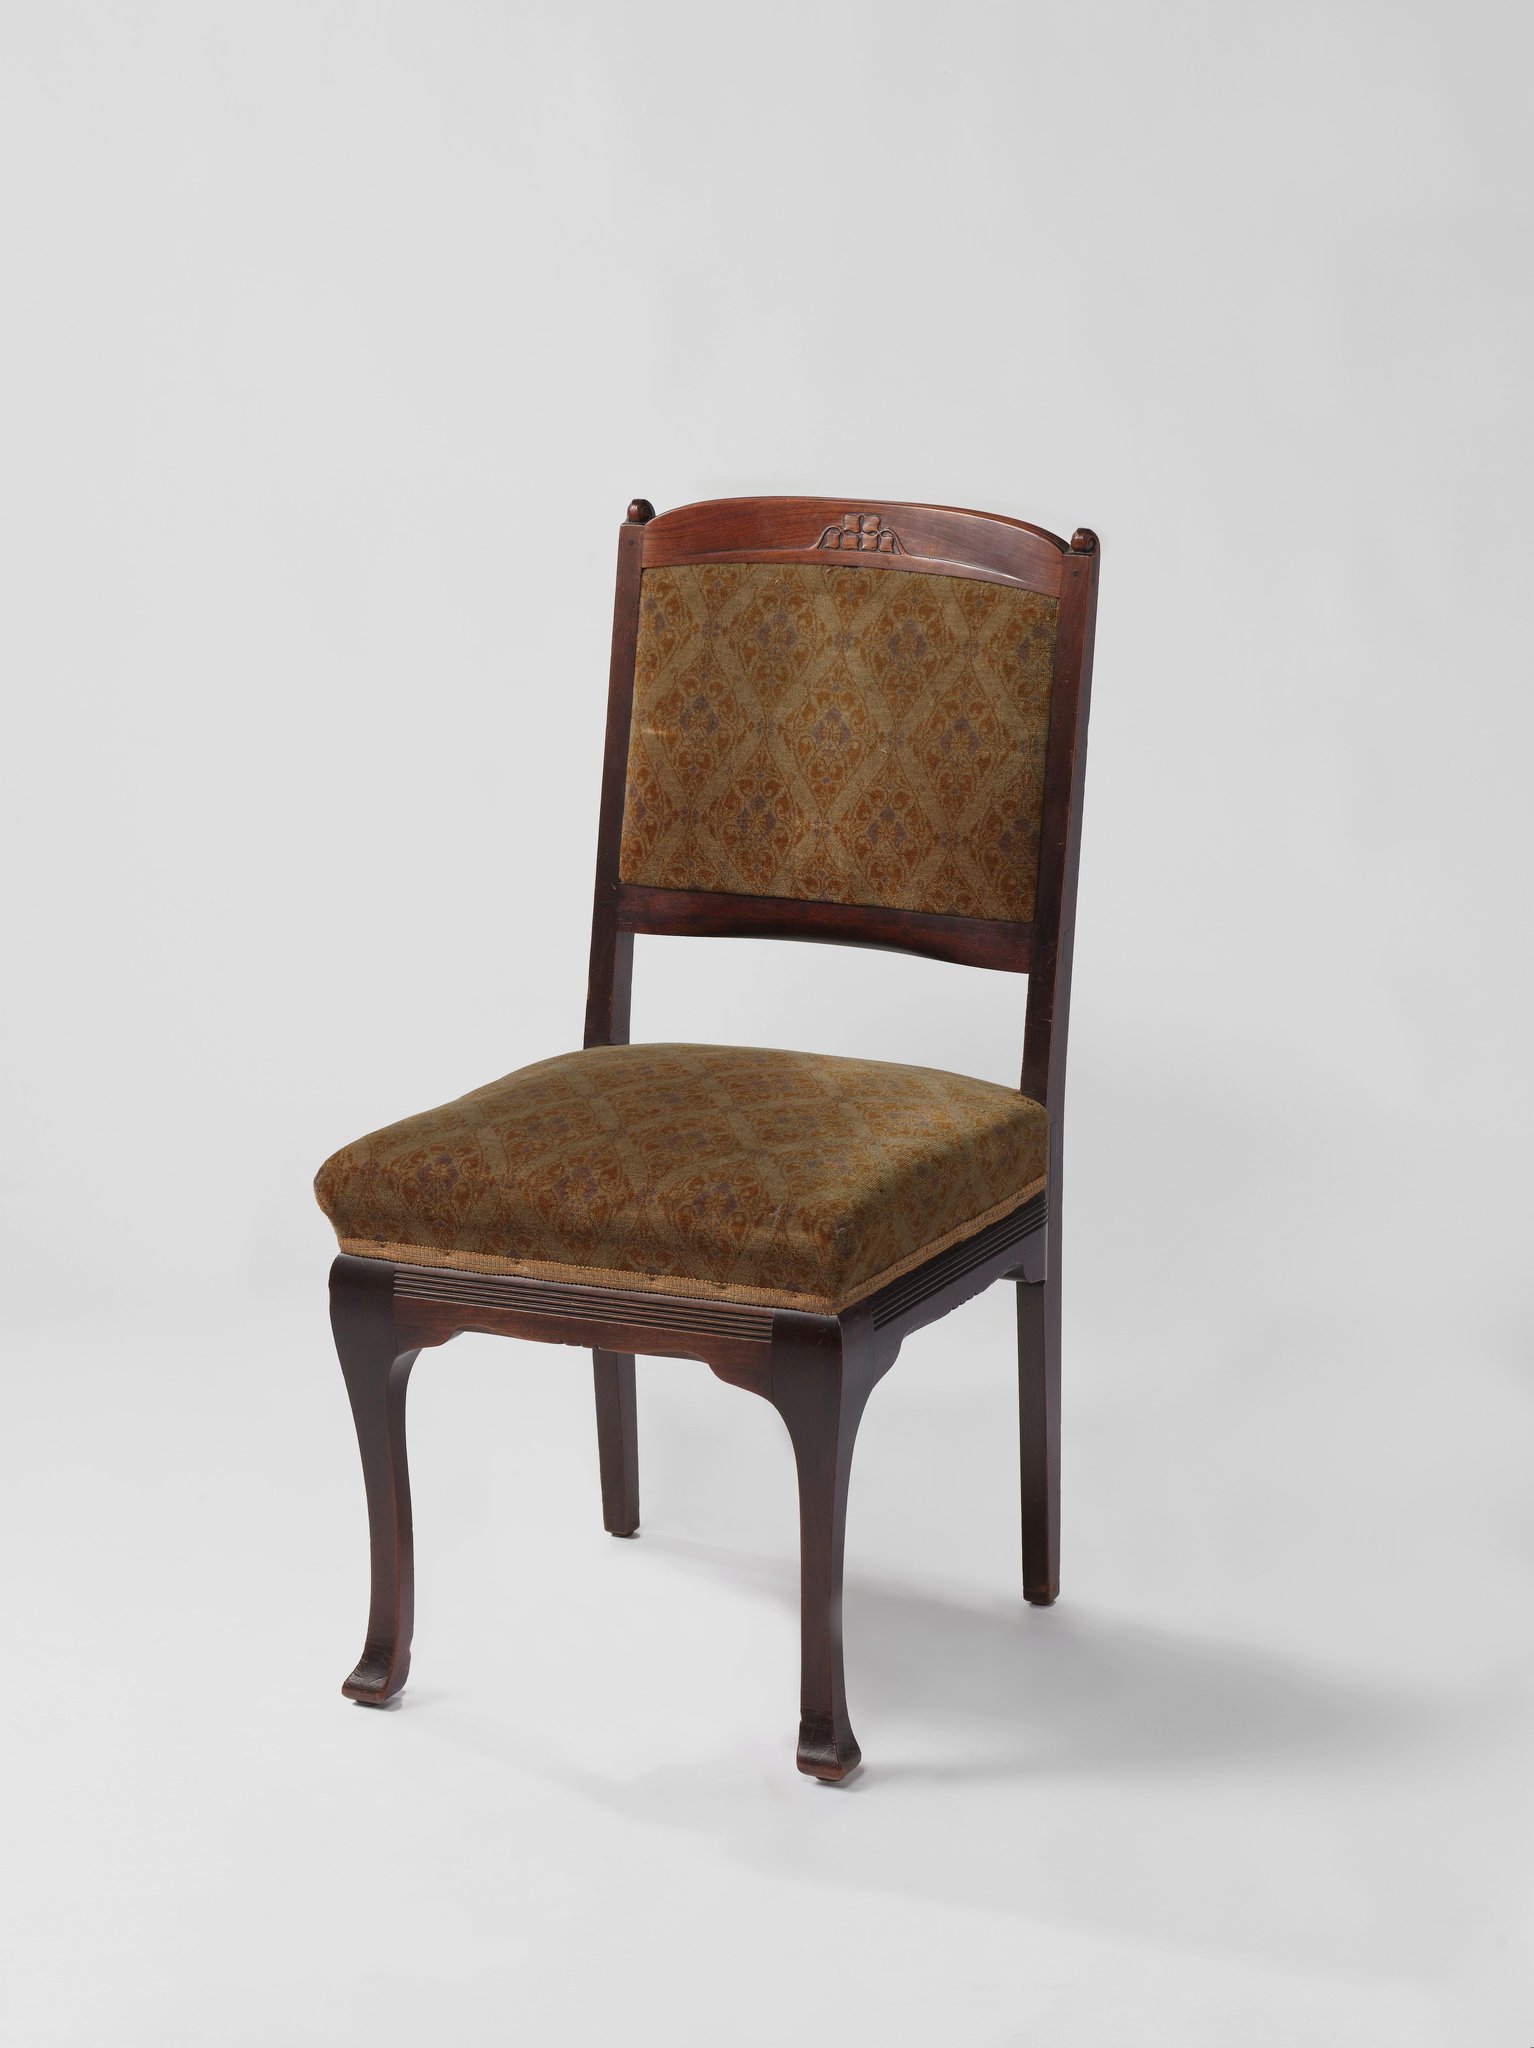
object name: suite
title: Stoel van bruin gebeitst mahoniehout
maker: theo nieuwenhuis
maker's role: designer, draughtsman, print maker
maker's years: 1866-1951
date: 1916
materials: wood, textile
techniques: staining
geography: northern netherlands